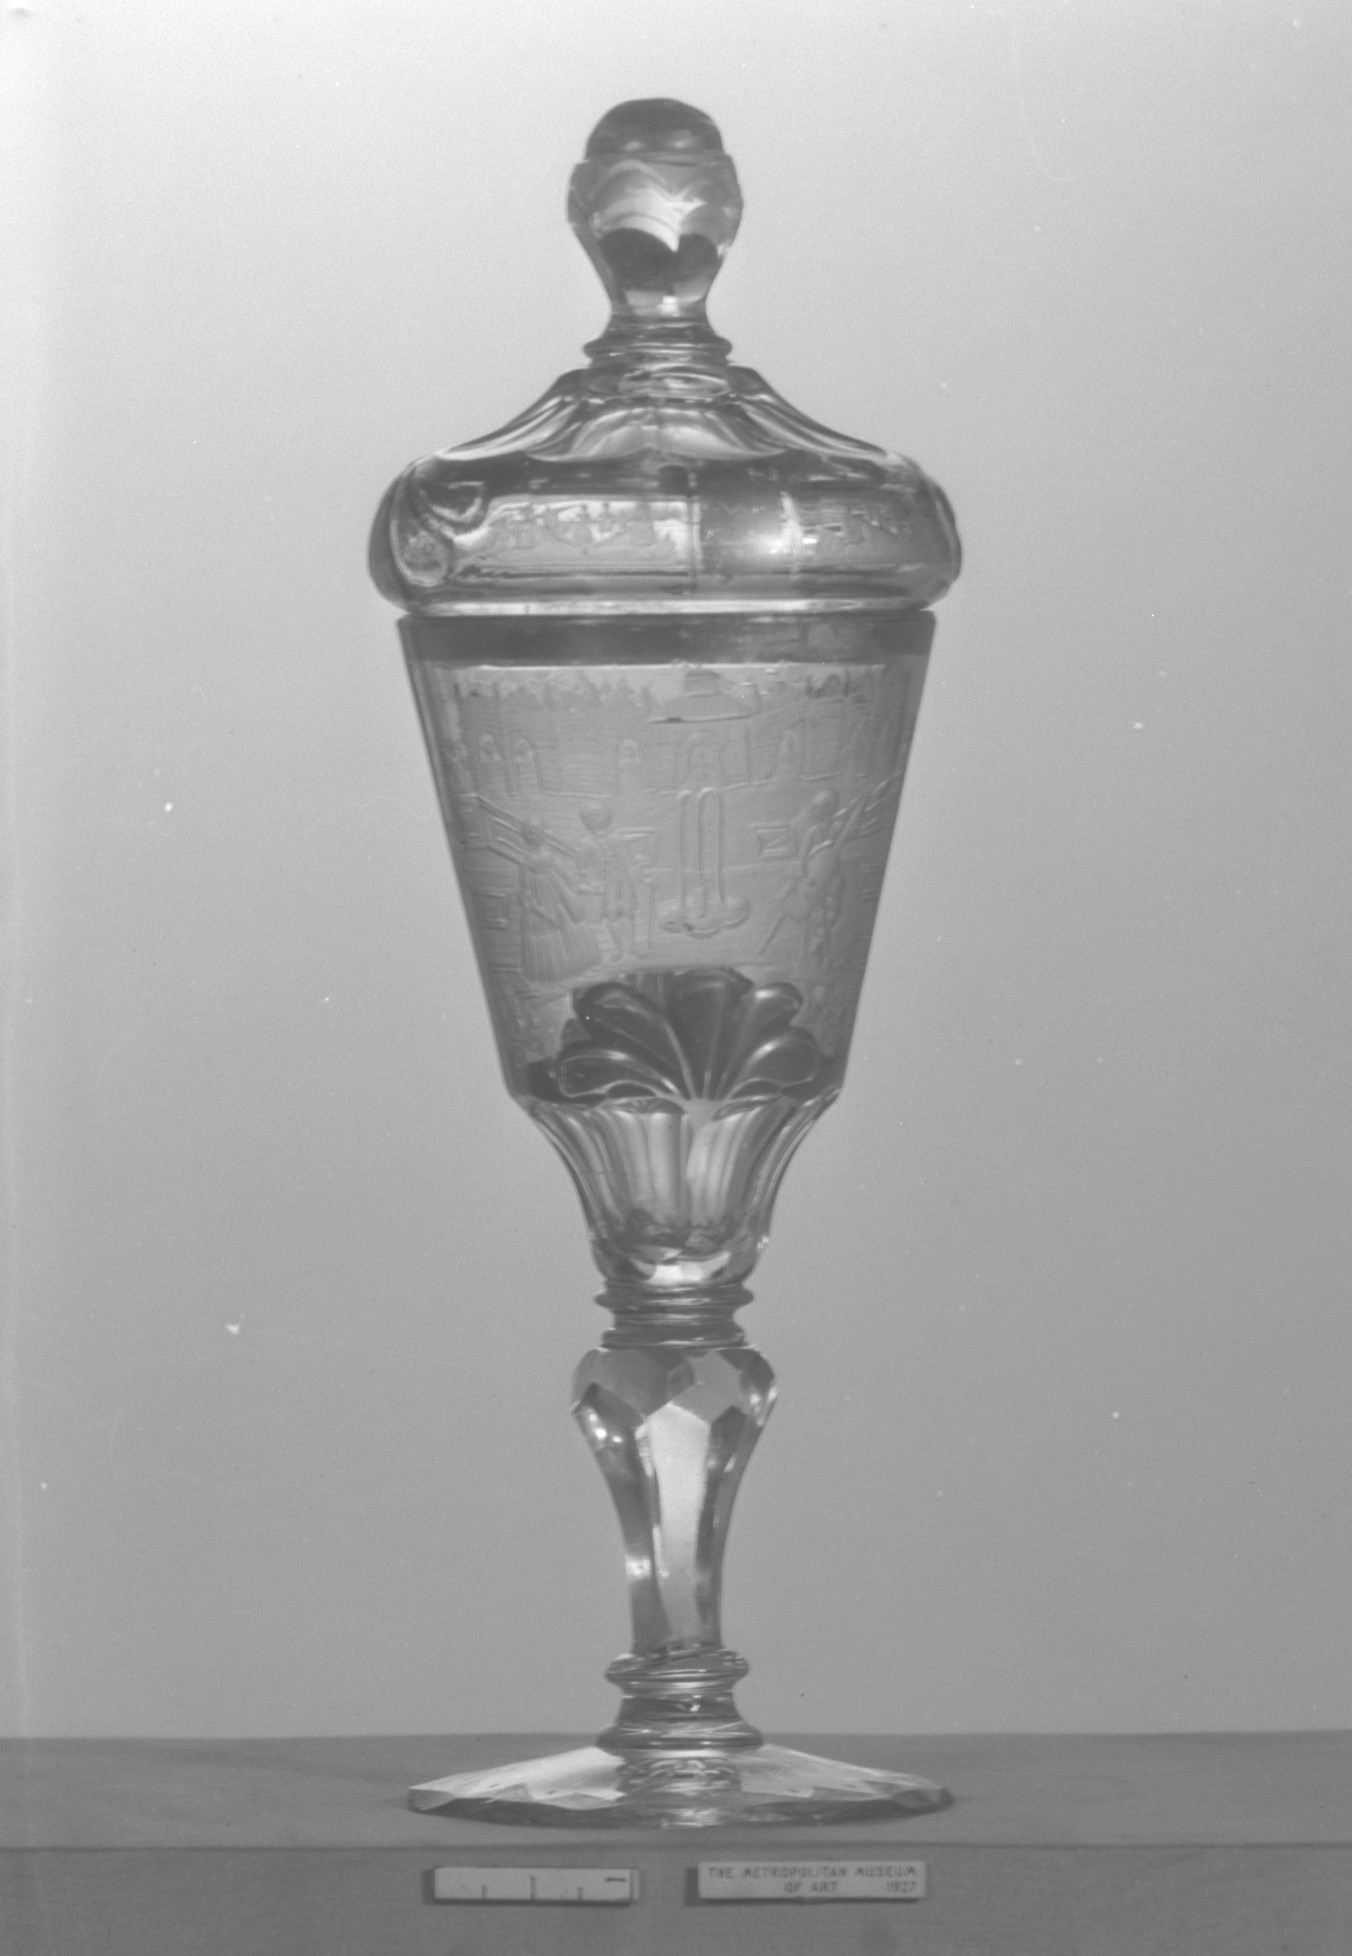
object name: standing cup with cover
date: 1745-1750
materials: glass